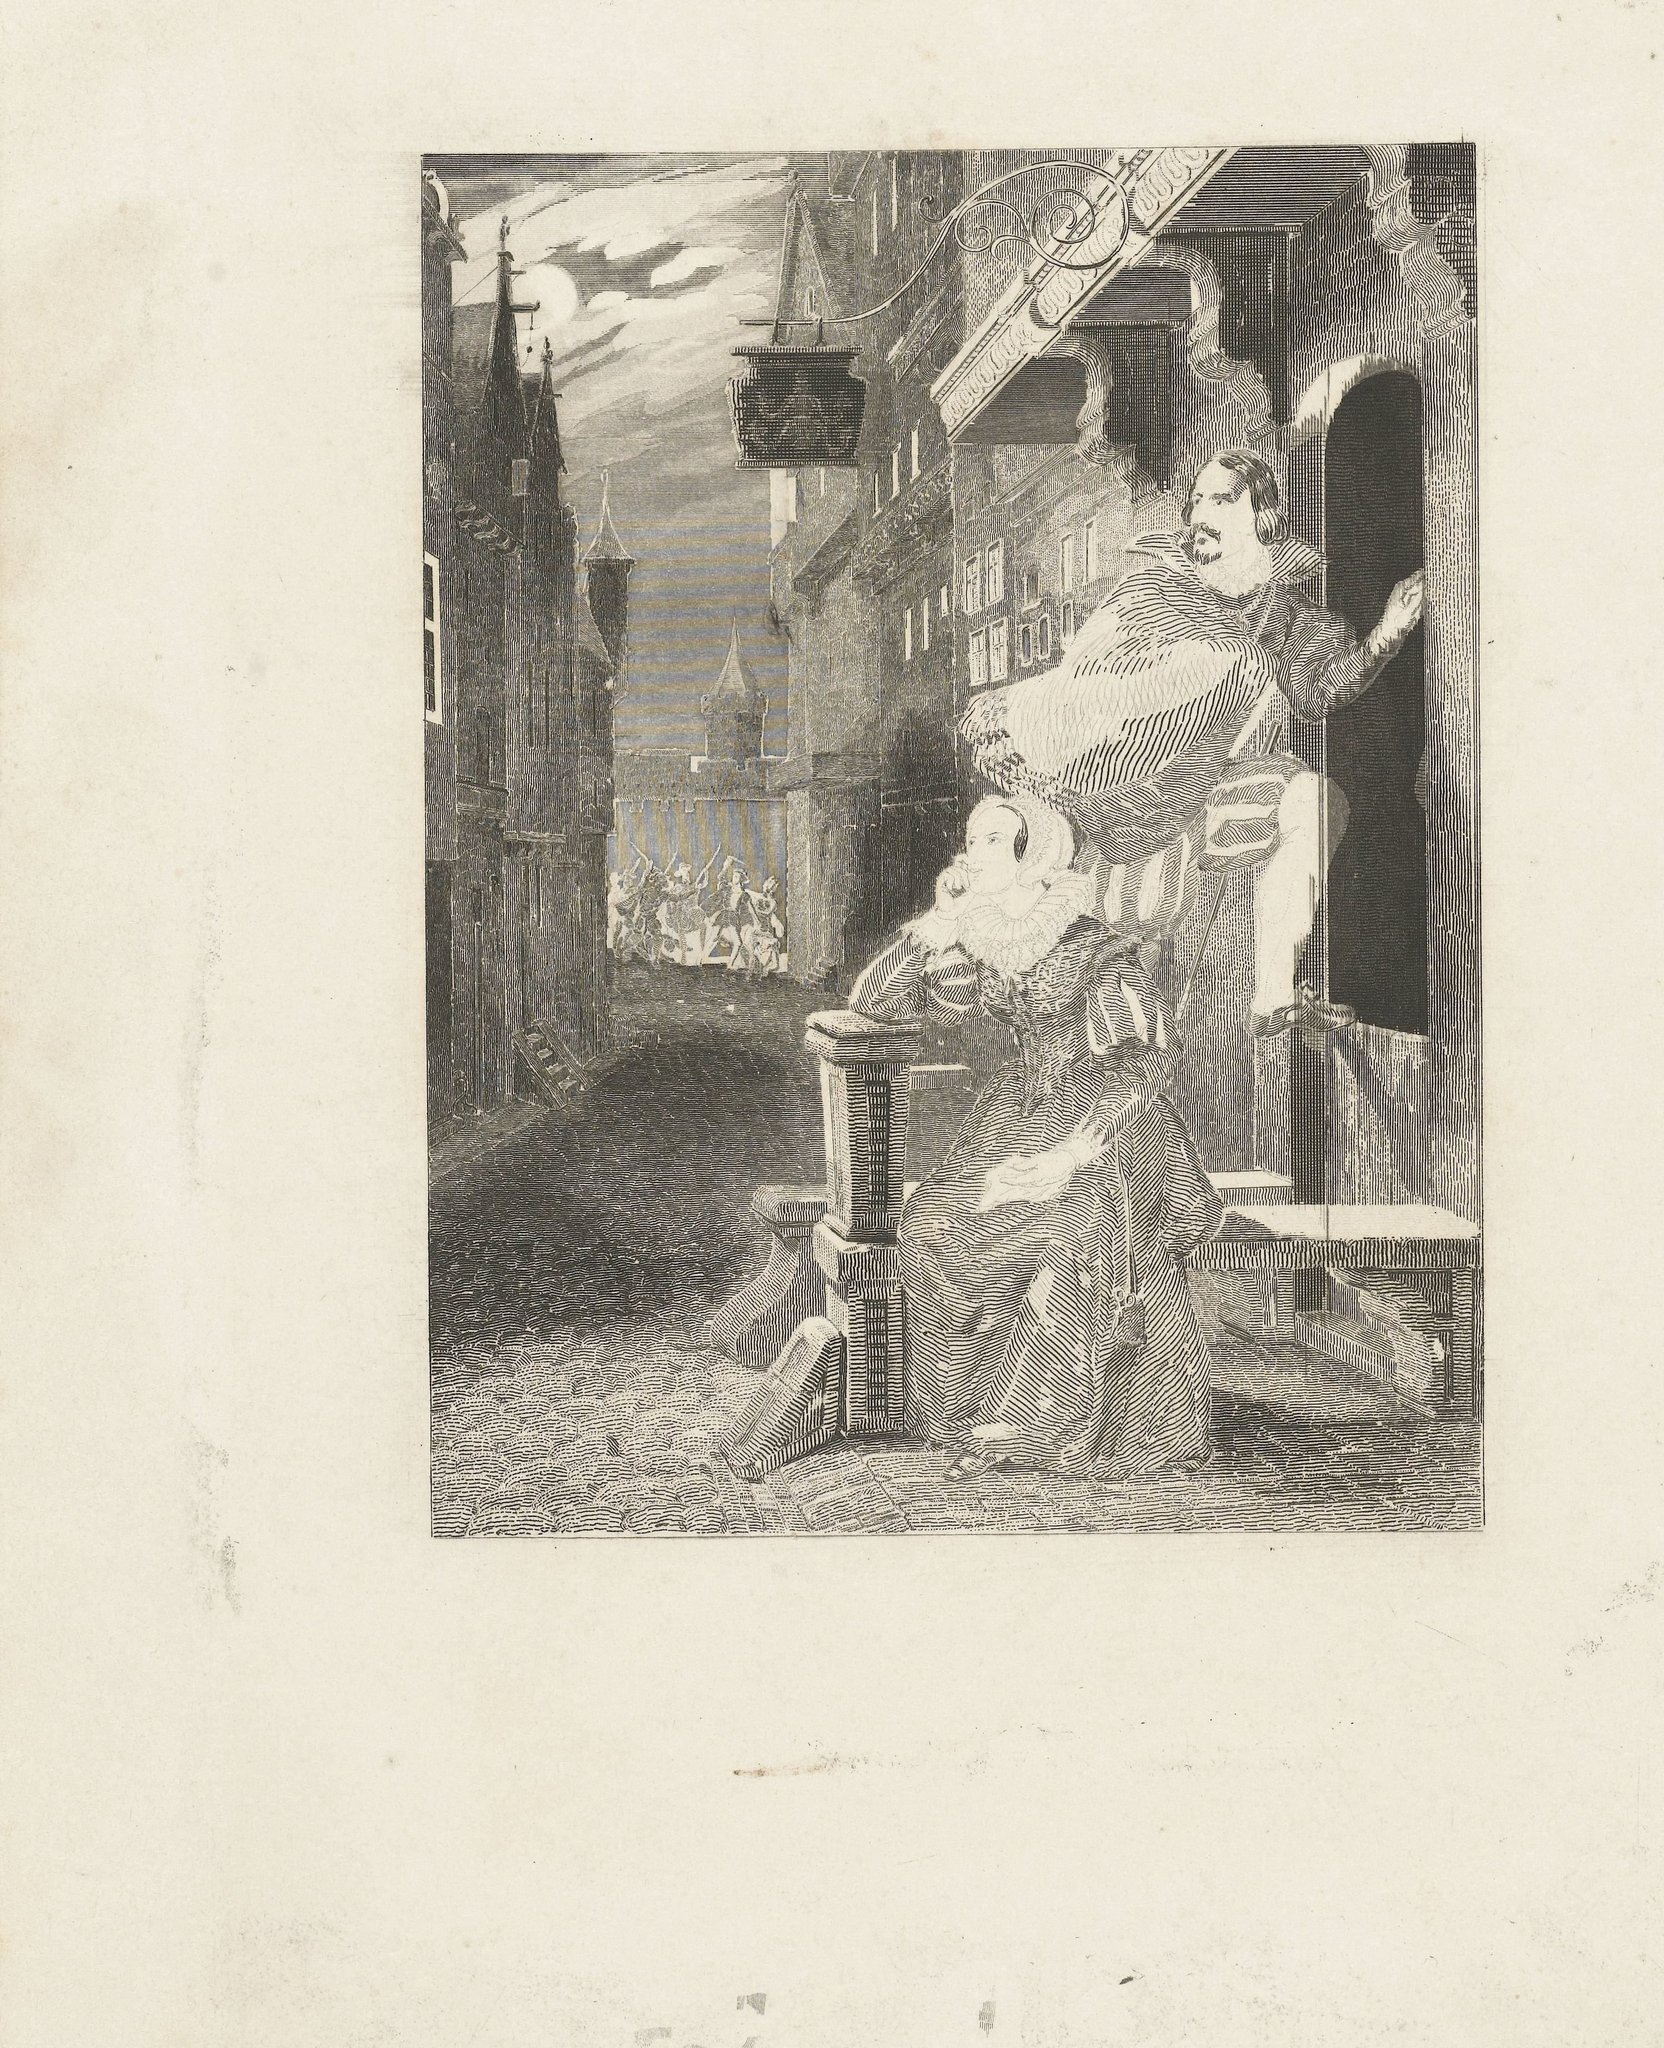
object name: print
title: Graaf Leicester vlucht in een huis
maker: henricus wilhelmus couwenberg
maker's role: draughtsman, print maker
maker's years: 1814-1845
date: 1841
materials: paper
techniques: engraving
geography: amsterdam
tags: robert dudley (1st earl of leicester), hiding, hiding oneself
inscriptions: collector's mark: Lugt 2228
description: Op de vlucht voor een oproerige muite vlucht graaf Leicester in een herberg. Voor het huis zit op een bank een vrouw die voor zich uit staart en hem niet schijnt op te merken.